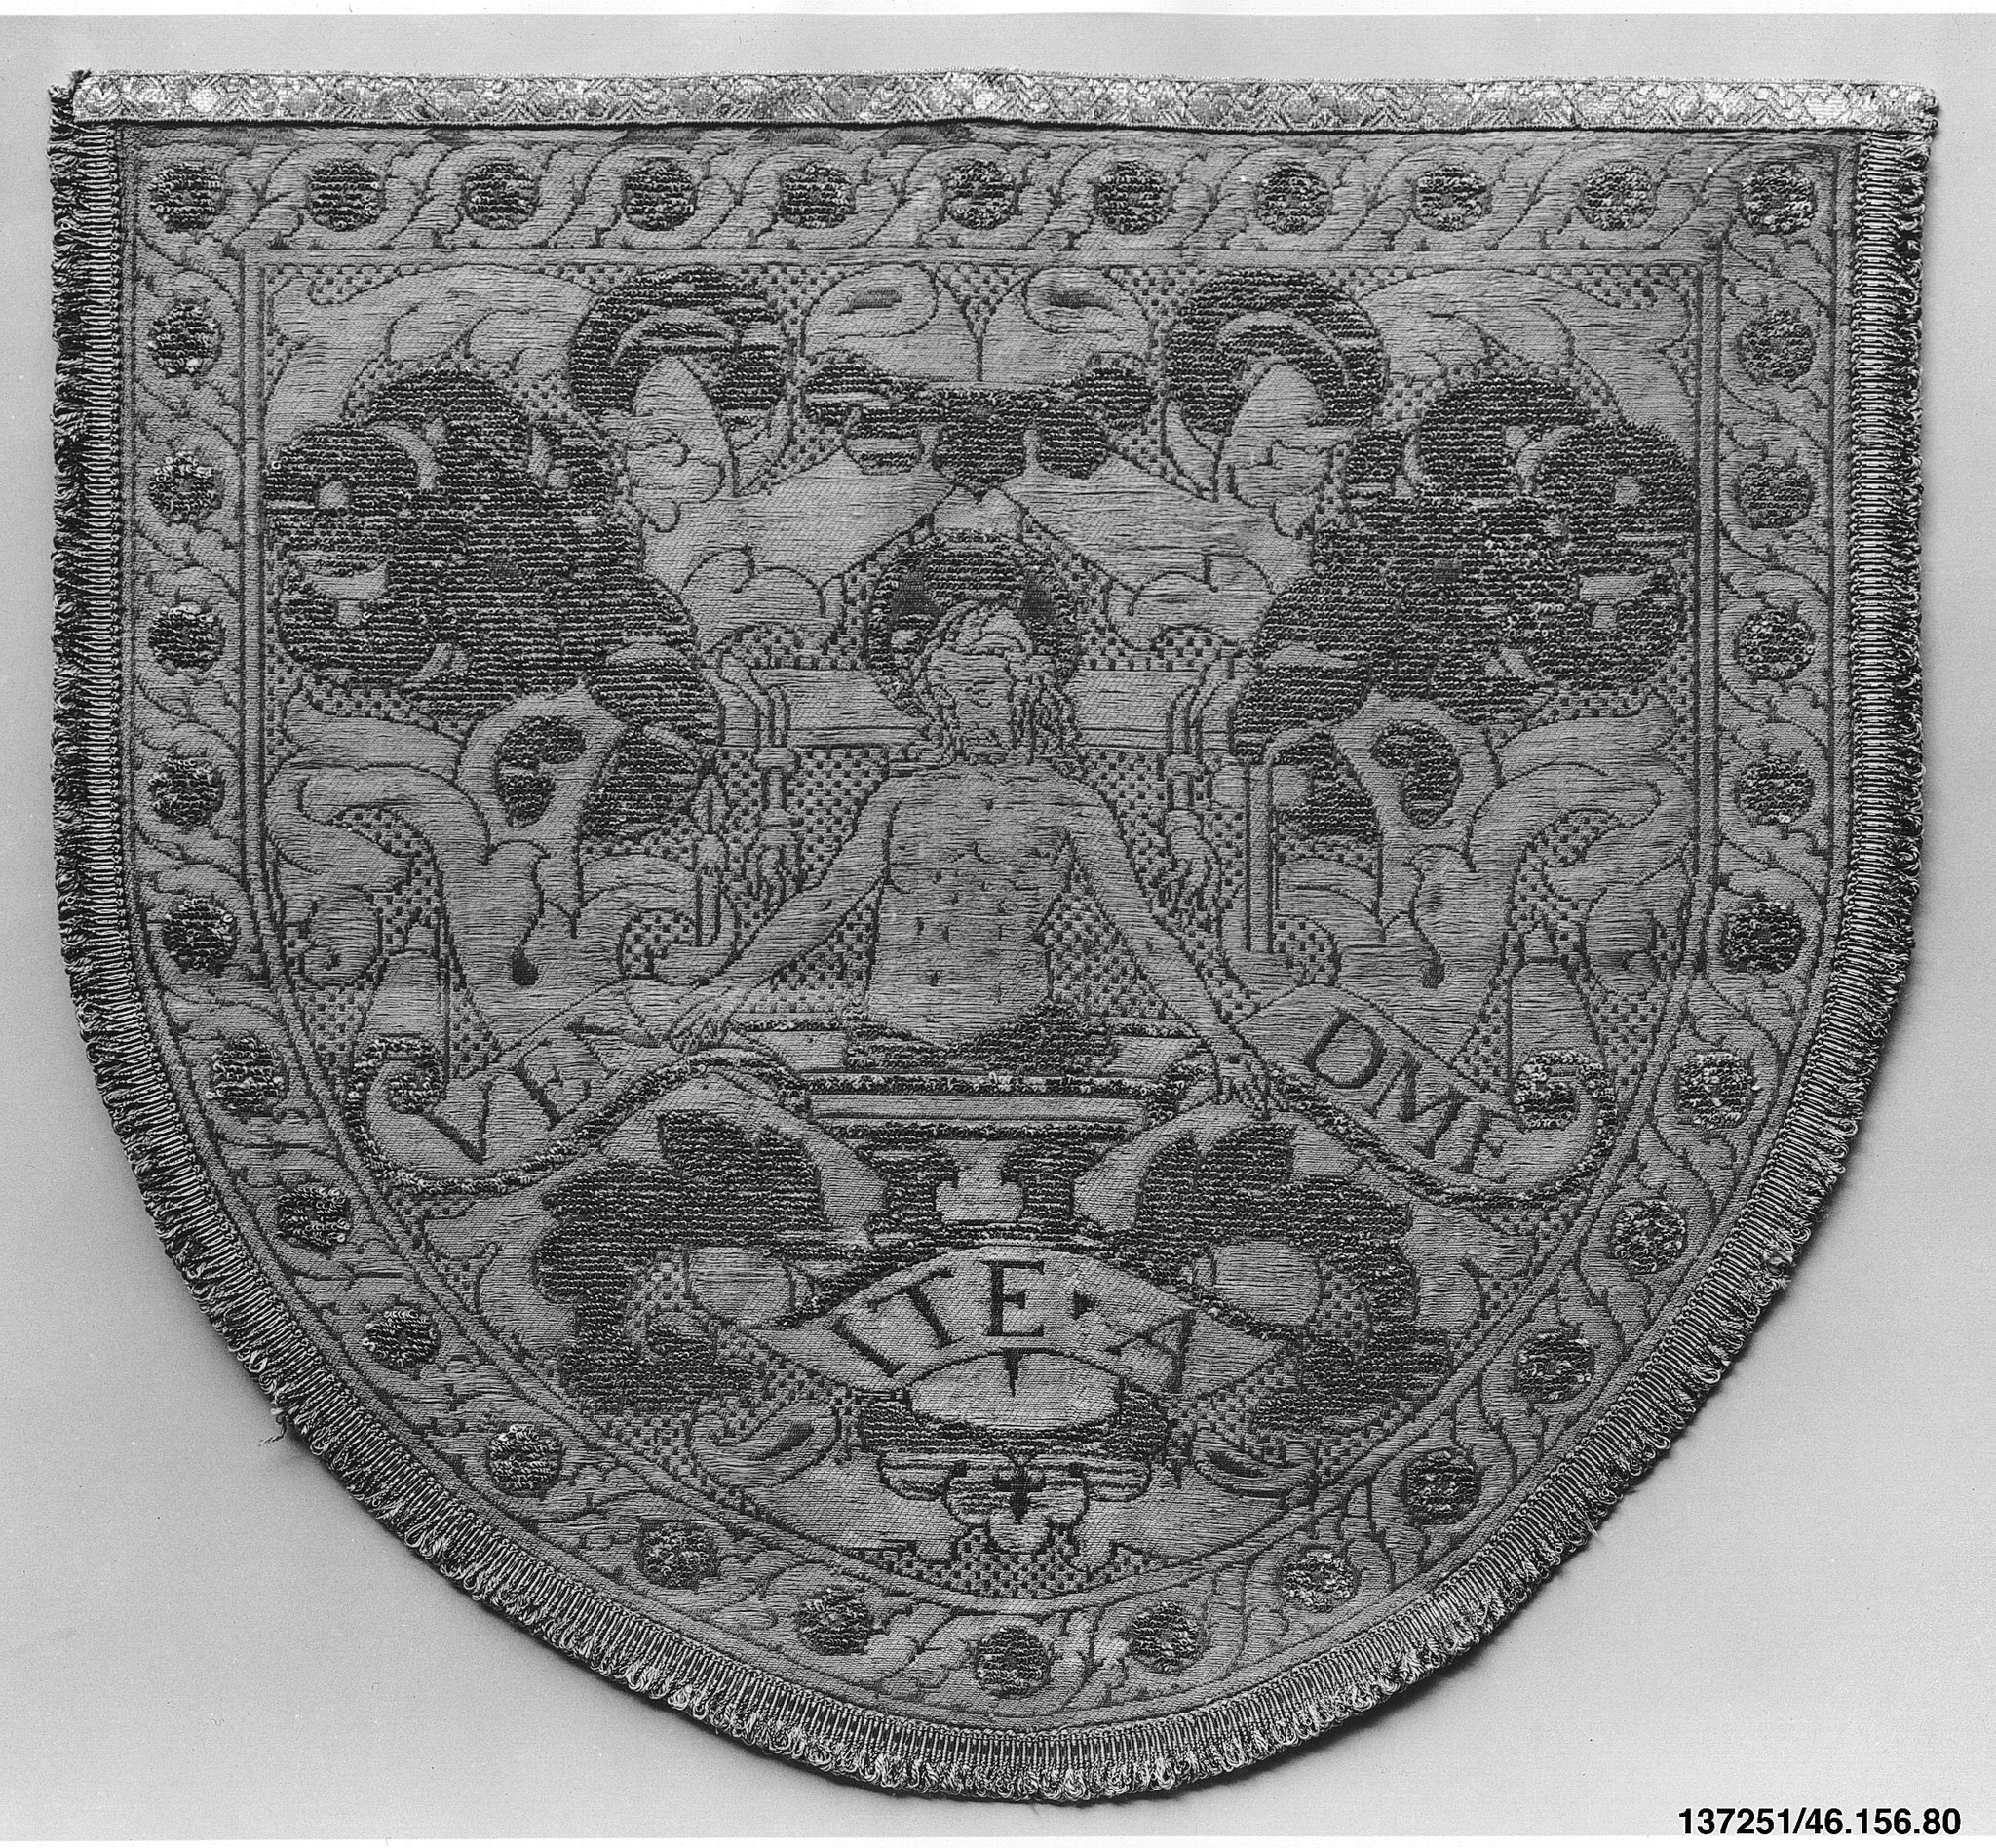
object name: hood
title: Hood for a cope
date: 1501-1533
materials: metal thread, silk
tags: christ